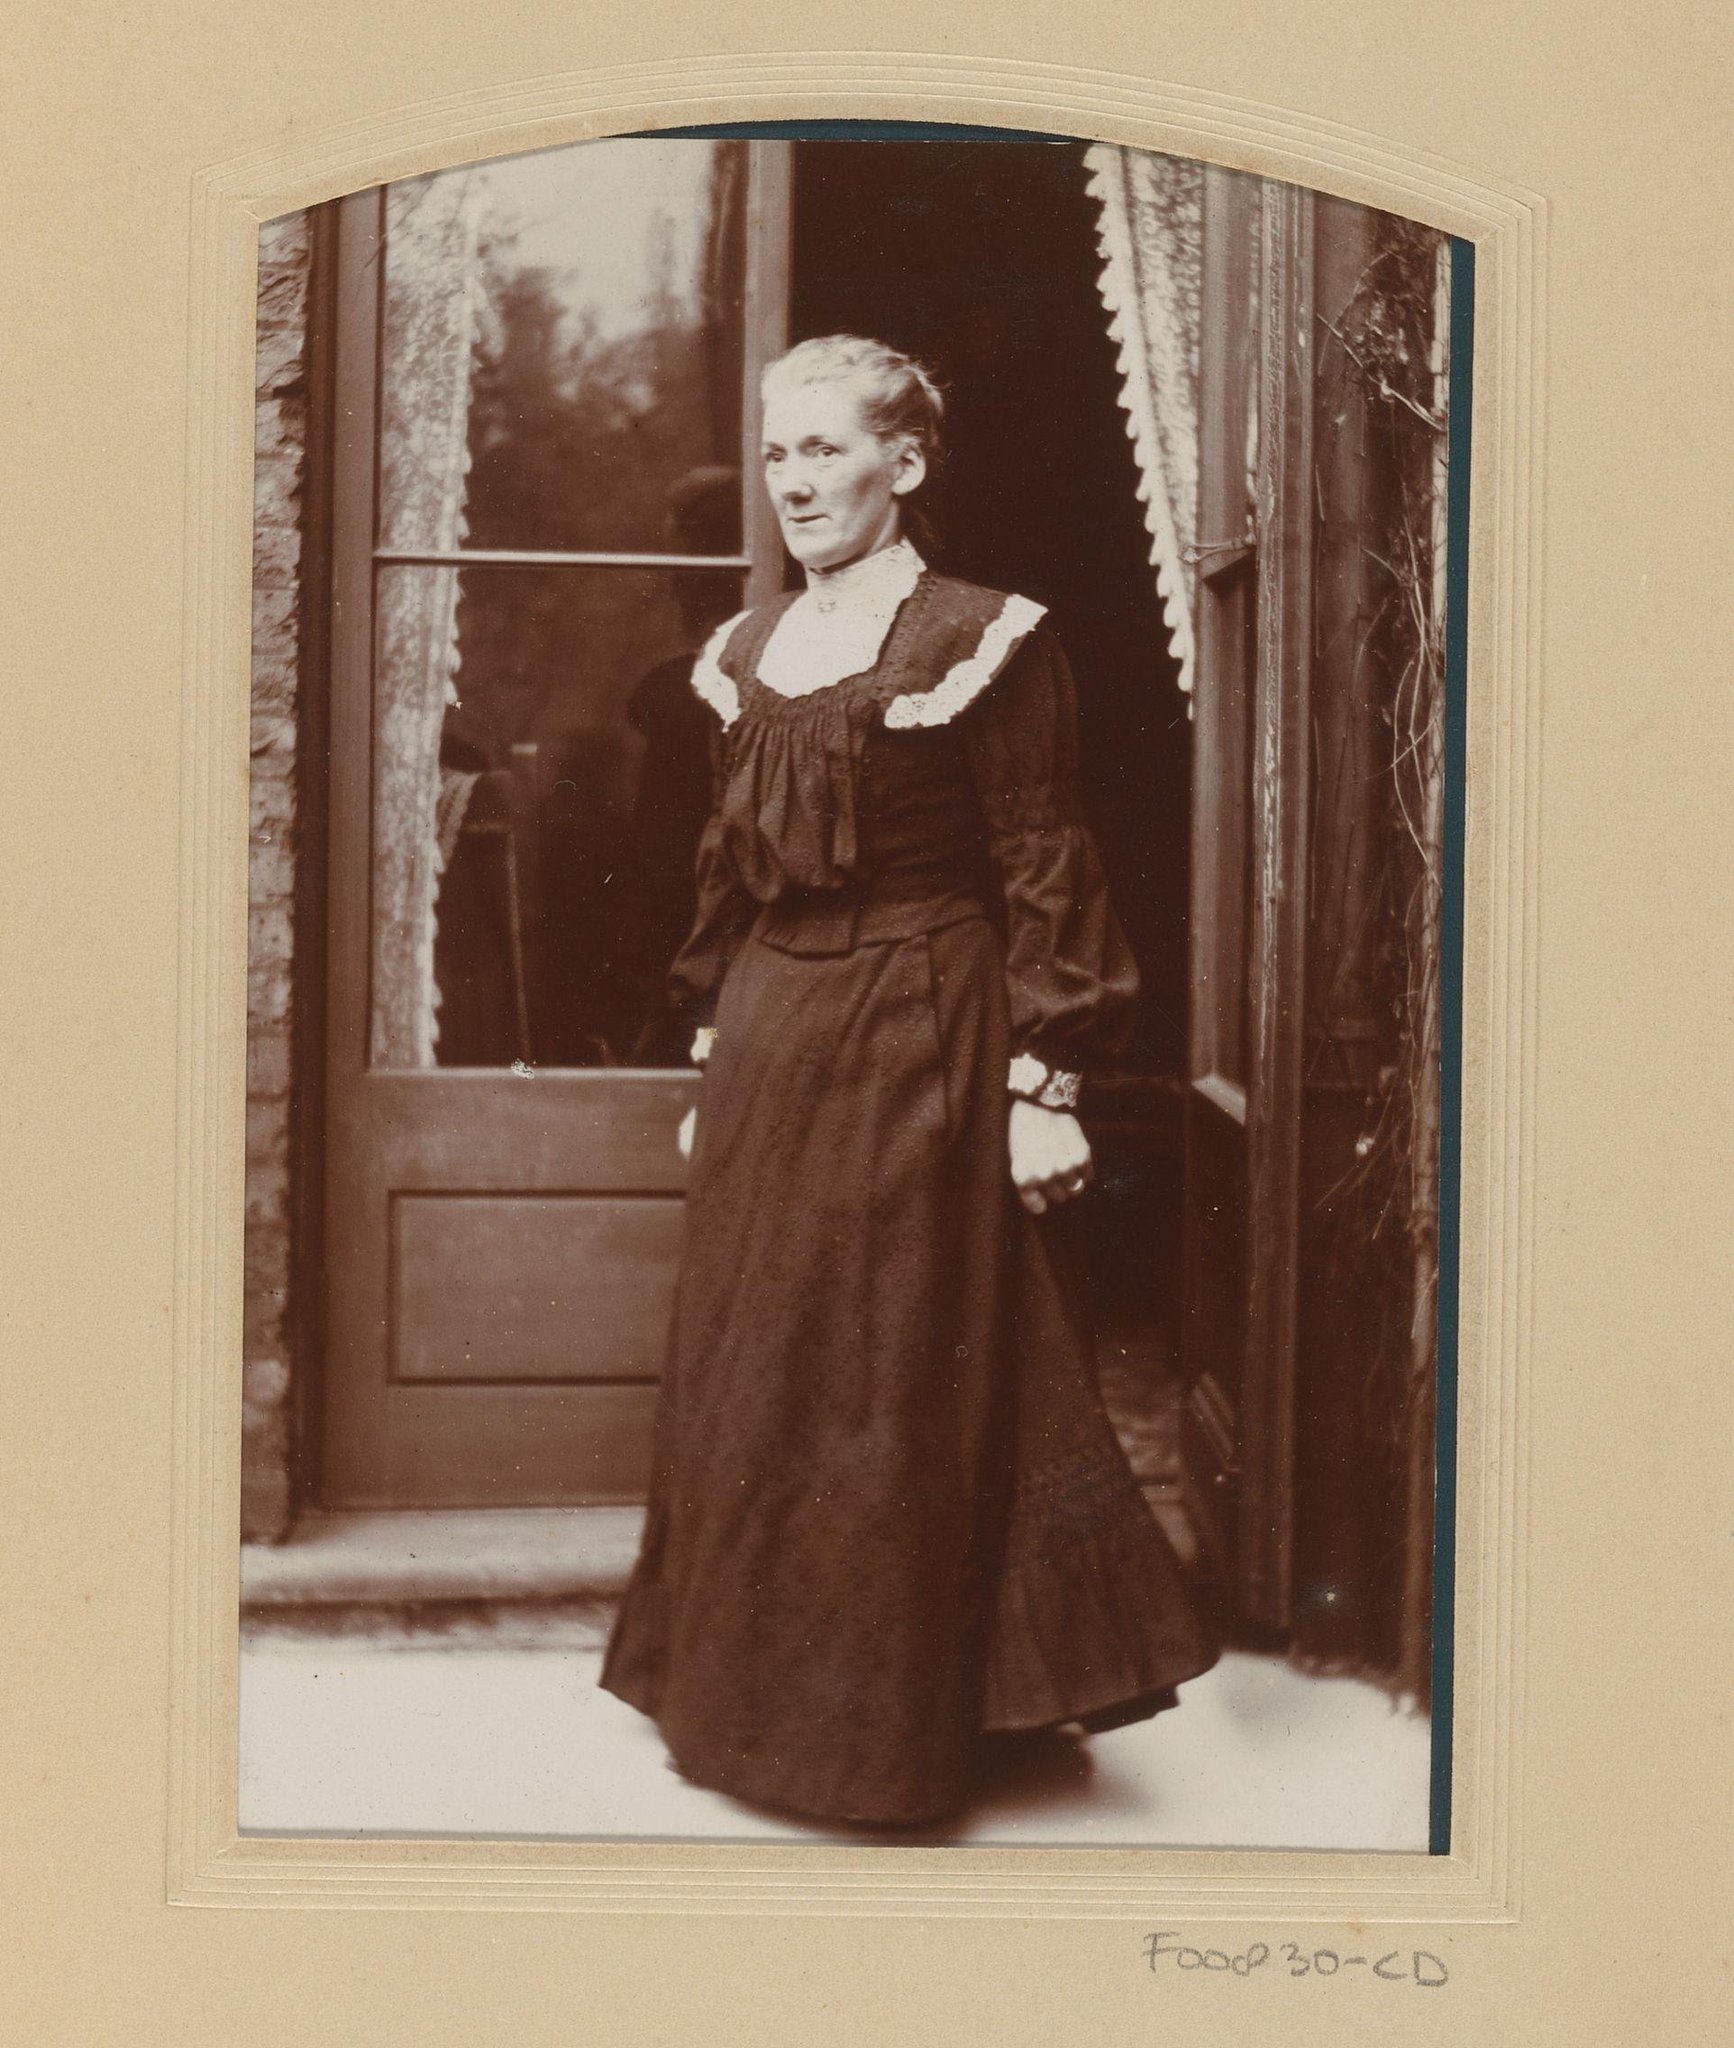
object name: photograph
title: Portret van een staande vrouw bij tuindeuren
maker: Anonymous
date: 1890-1910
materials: cardboard, photographic support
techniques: collodion silver print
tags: adult woman, open door, historical persons